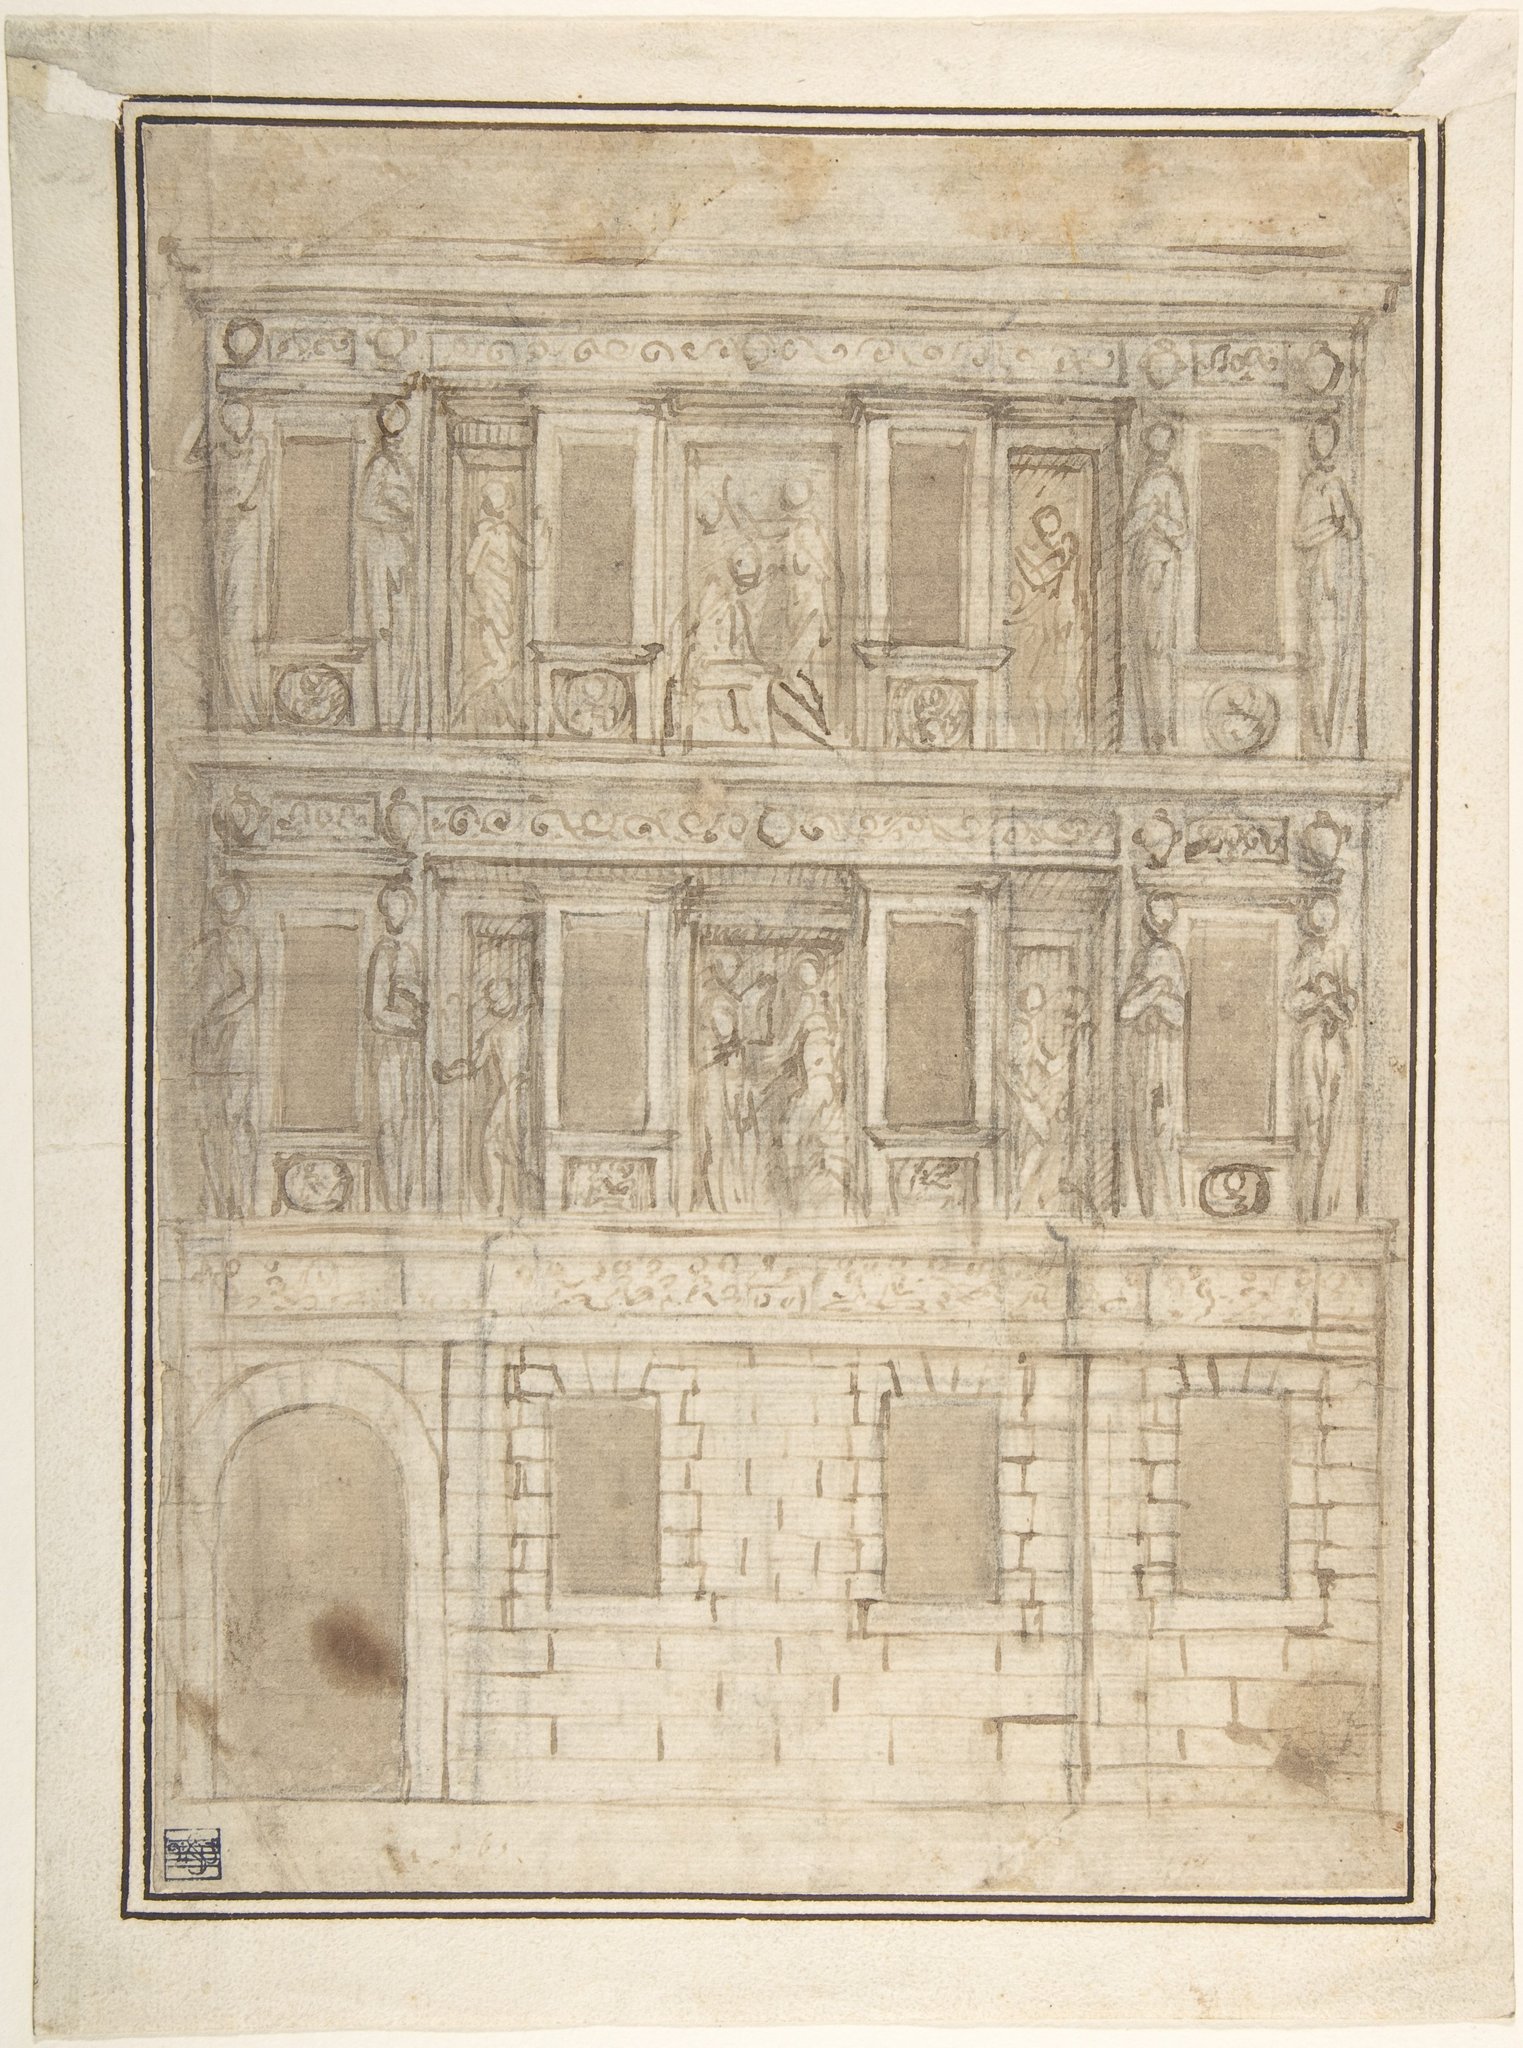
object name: drawing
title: Project for a Façade Decoration (recto); Architectural Studies (verso)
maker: lattanzio gambara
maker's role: artist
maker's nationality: italian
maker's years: 1525-1574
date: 1501-1600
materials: chalk, ink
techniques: brush, pen, wash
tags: architecture,buildings